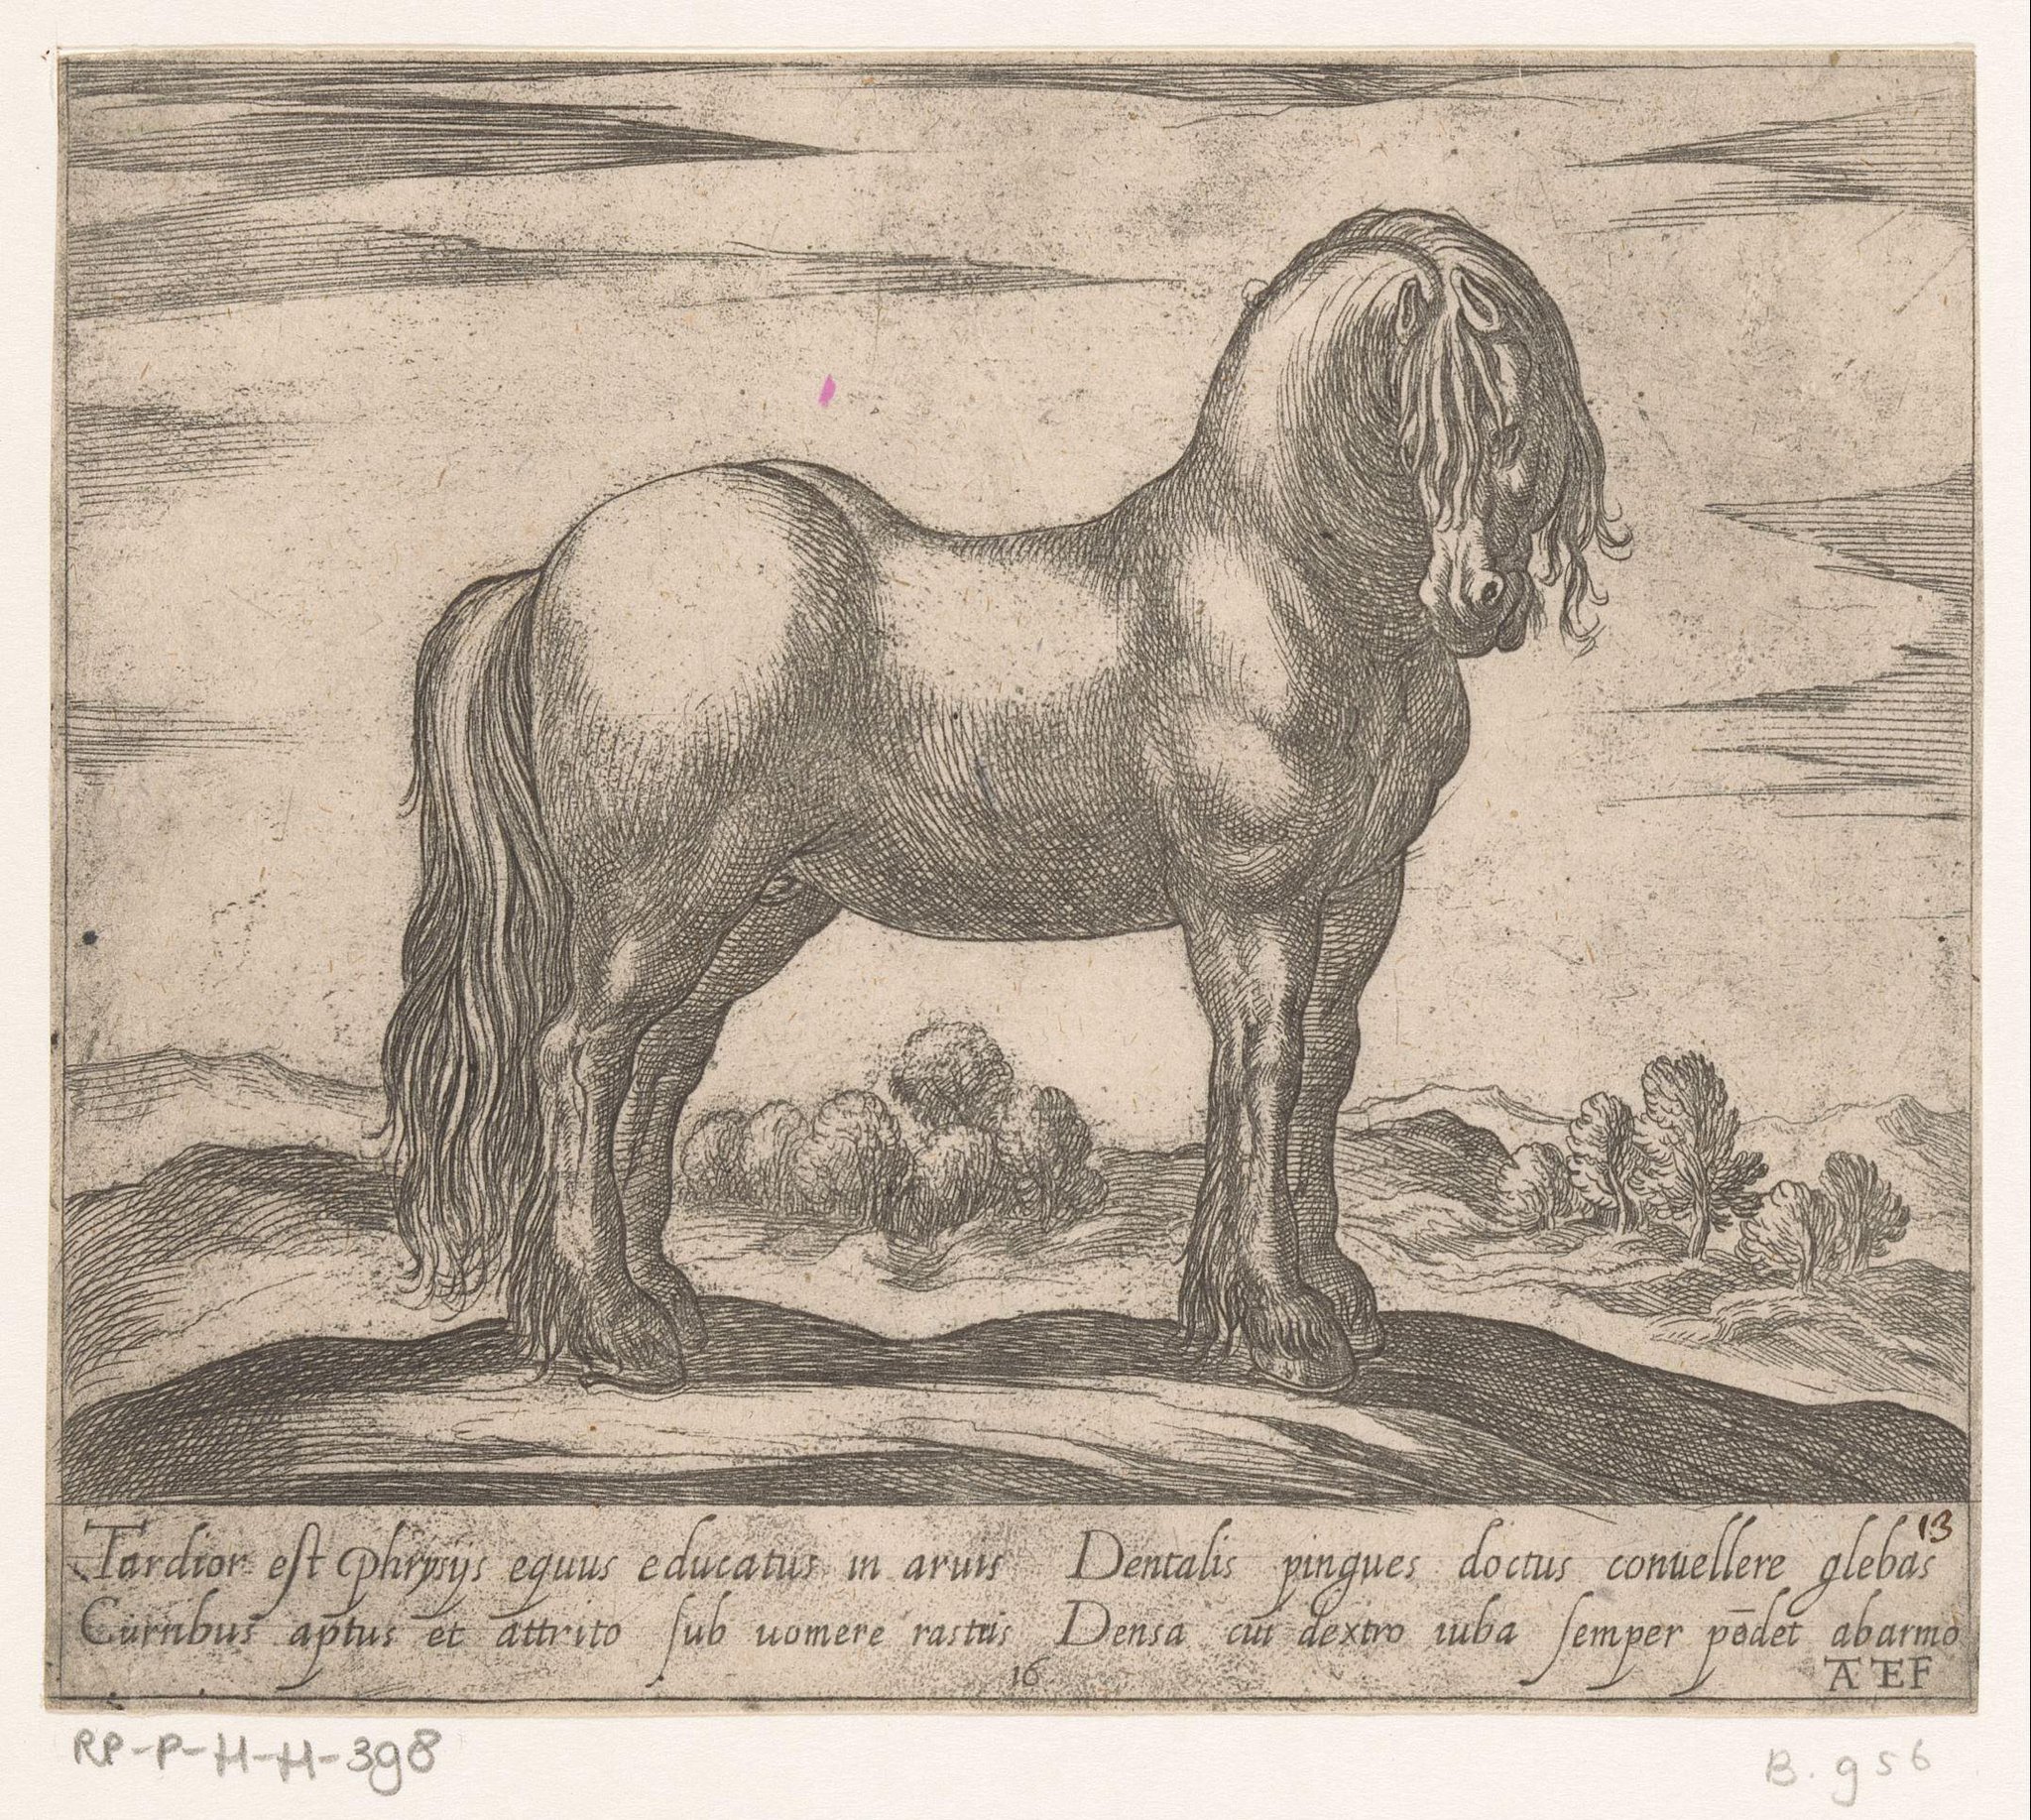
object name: print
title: His ducibus princeps celebraberis ore viroru illa homines beat haec sideribusq locat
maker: antonio tempesta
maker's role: draughtsman, painter, print maker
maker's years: 1555-1630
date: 1590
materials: paper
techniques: etching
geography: italy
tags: horse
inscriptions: number: ‘13’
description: Deze prent maakt deel uit van een reeks van 28 prenten van paarden (+ titelprent en opdracht).